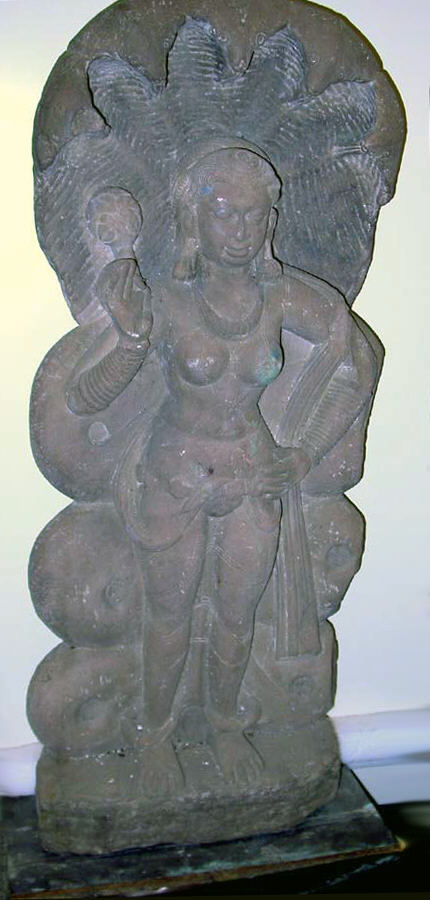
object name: figure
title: Standing Nagini (Study Collection)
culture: indian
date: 1901-2000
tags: female nudes,mythical creatures,snakes